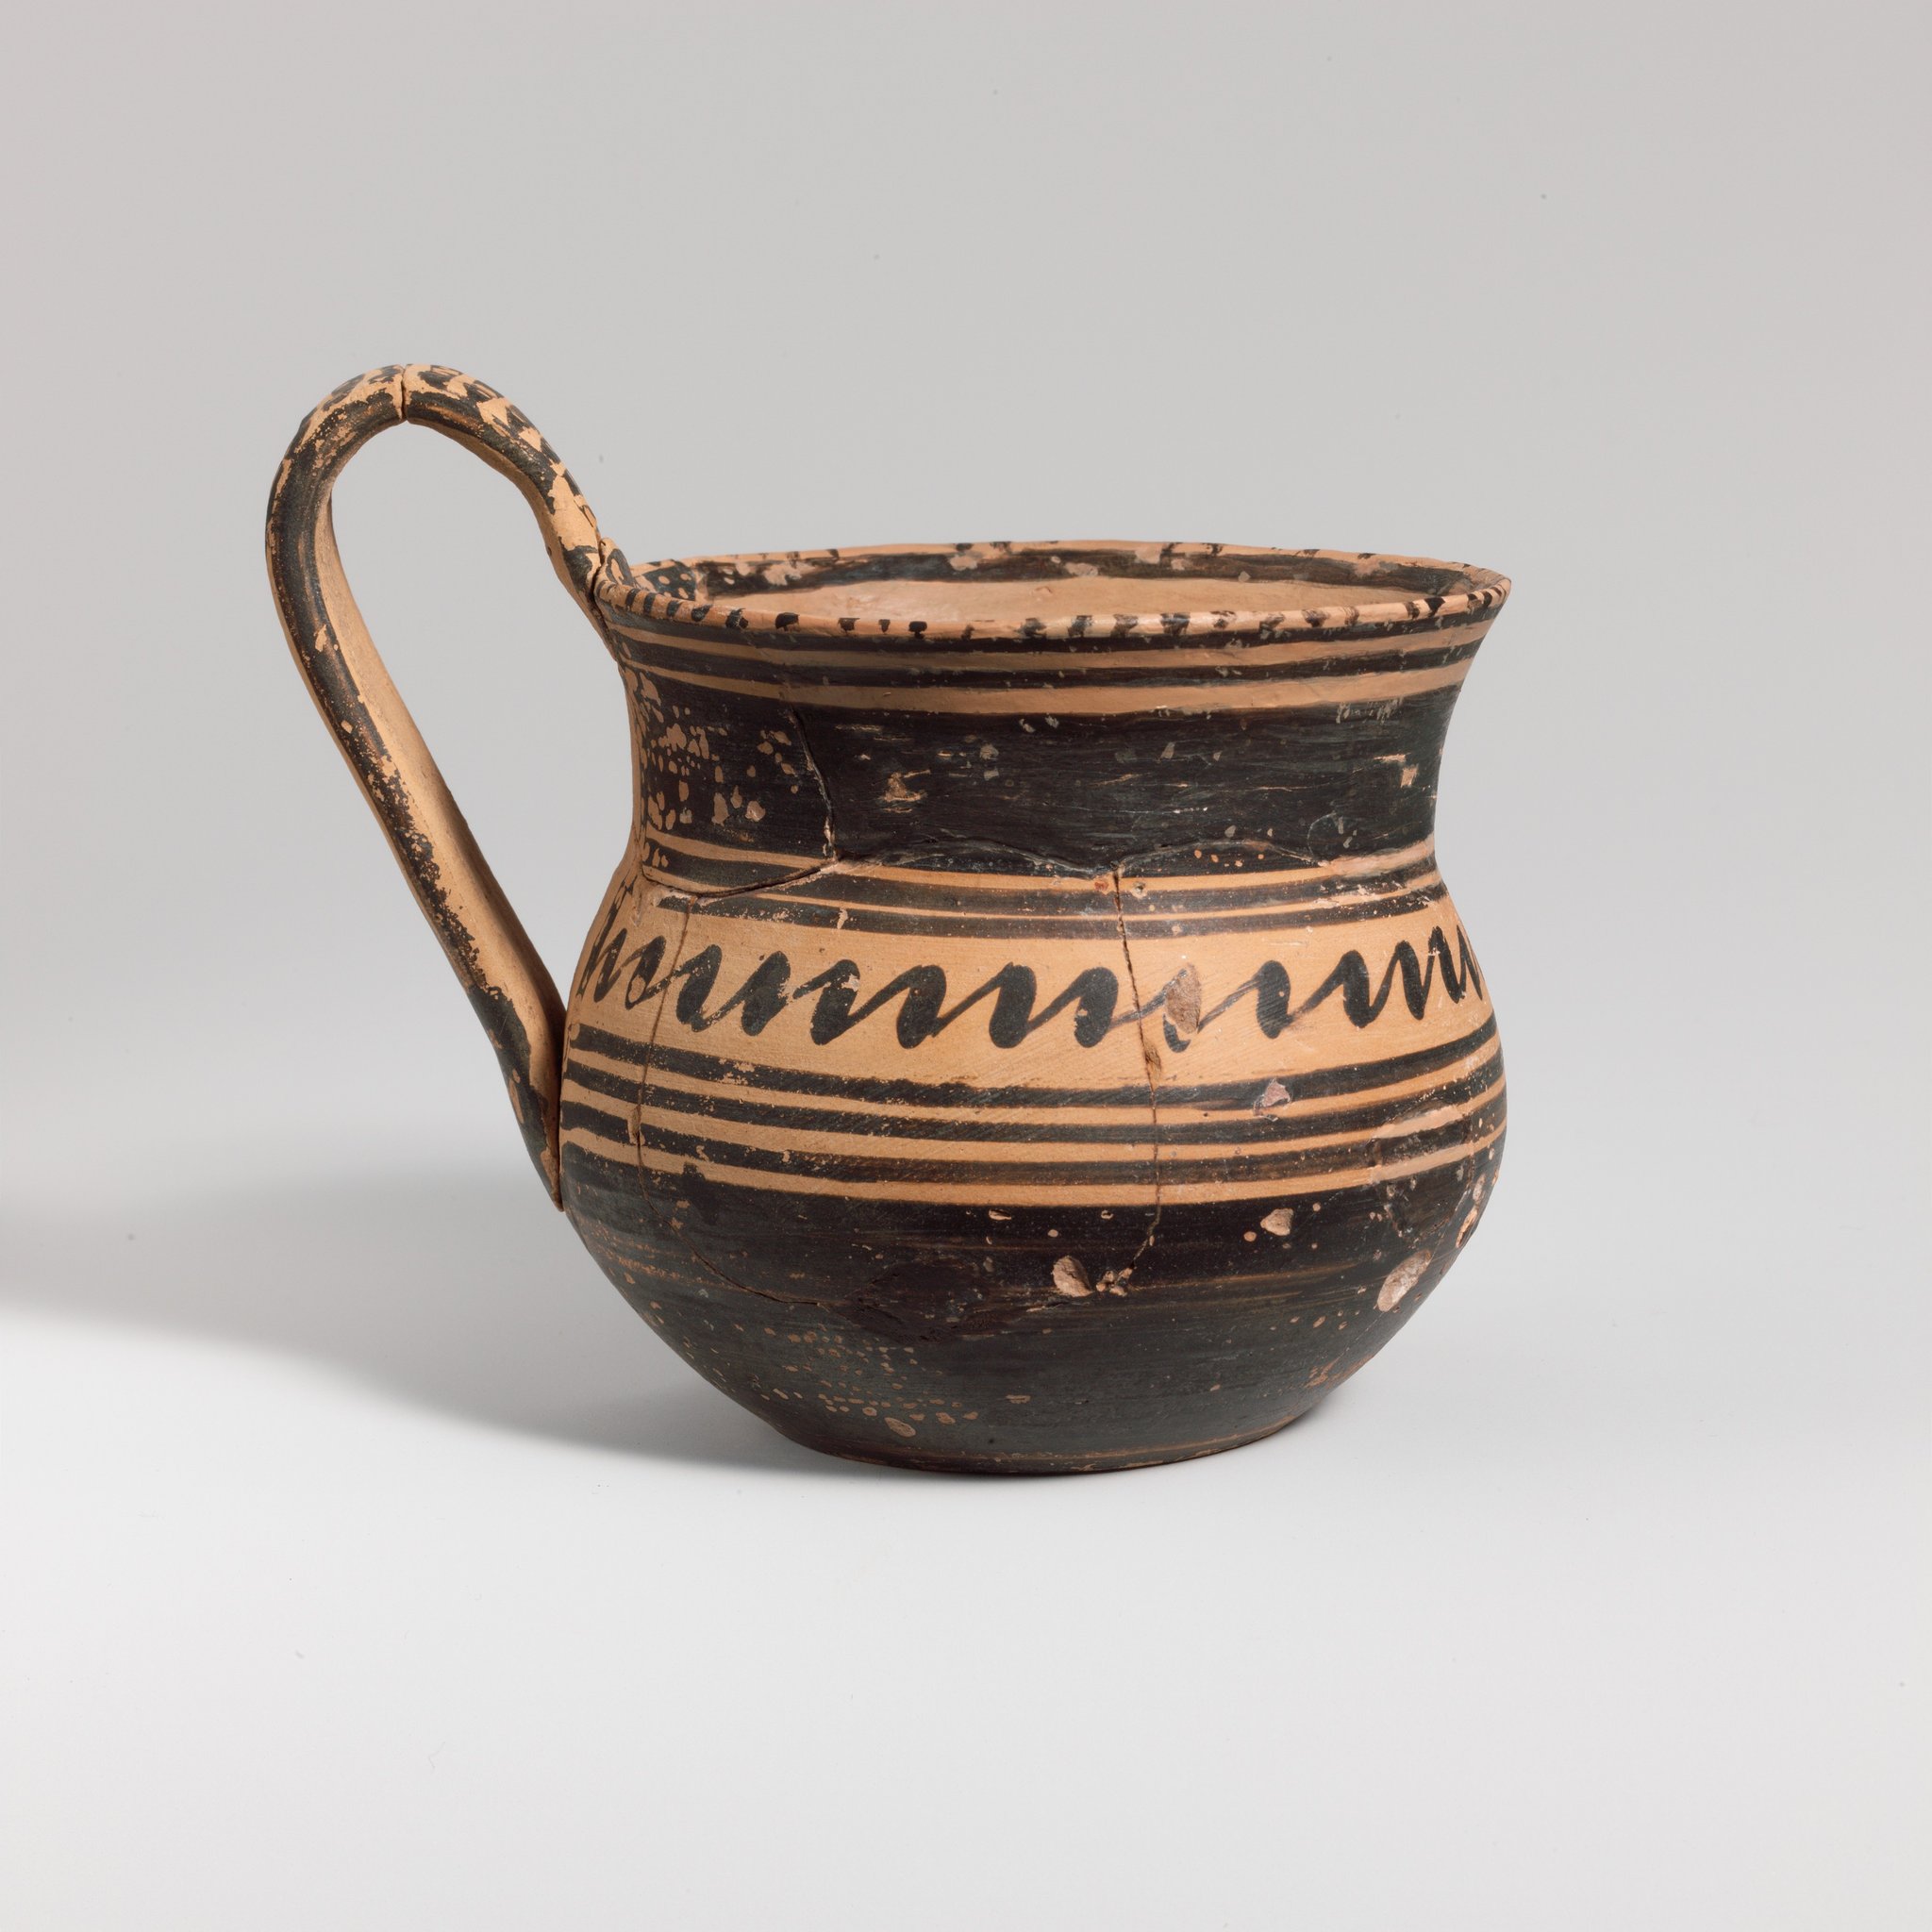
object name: tankard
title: Terracotta tankard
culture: greek, attic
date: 734-701 BCE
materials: terracotta